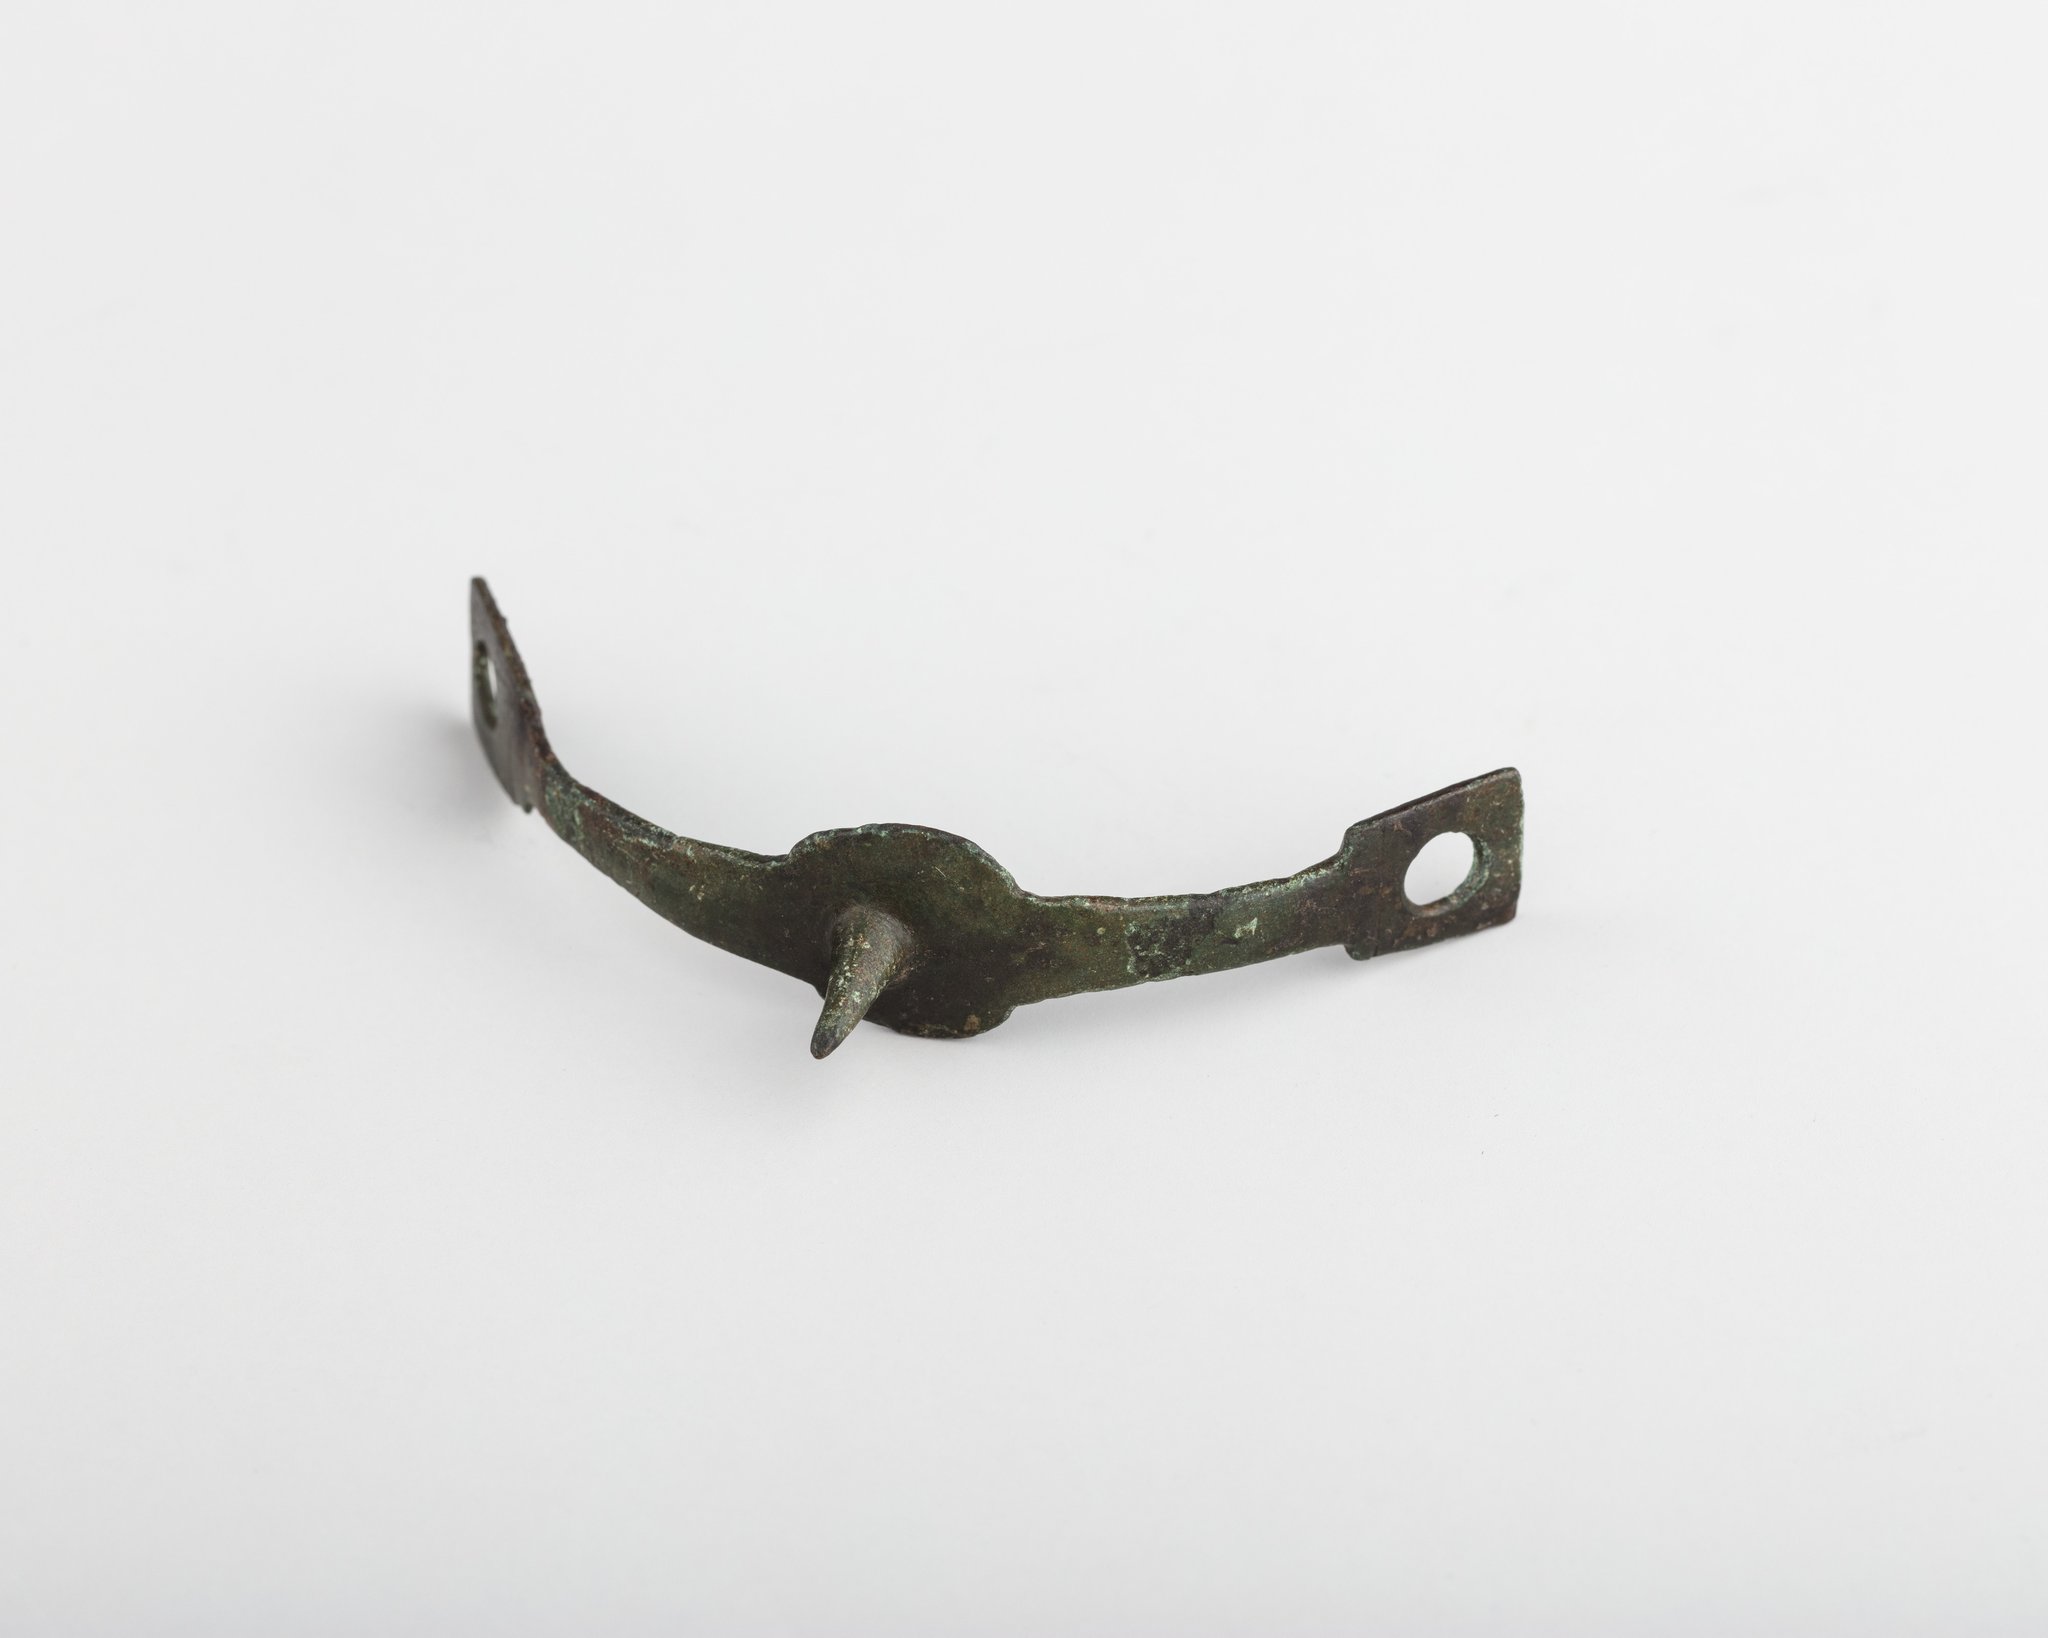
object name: spur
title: Prick Spur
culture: celtic or roman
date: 200-1 BCE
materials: copper alloy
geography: europe